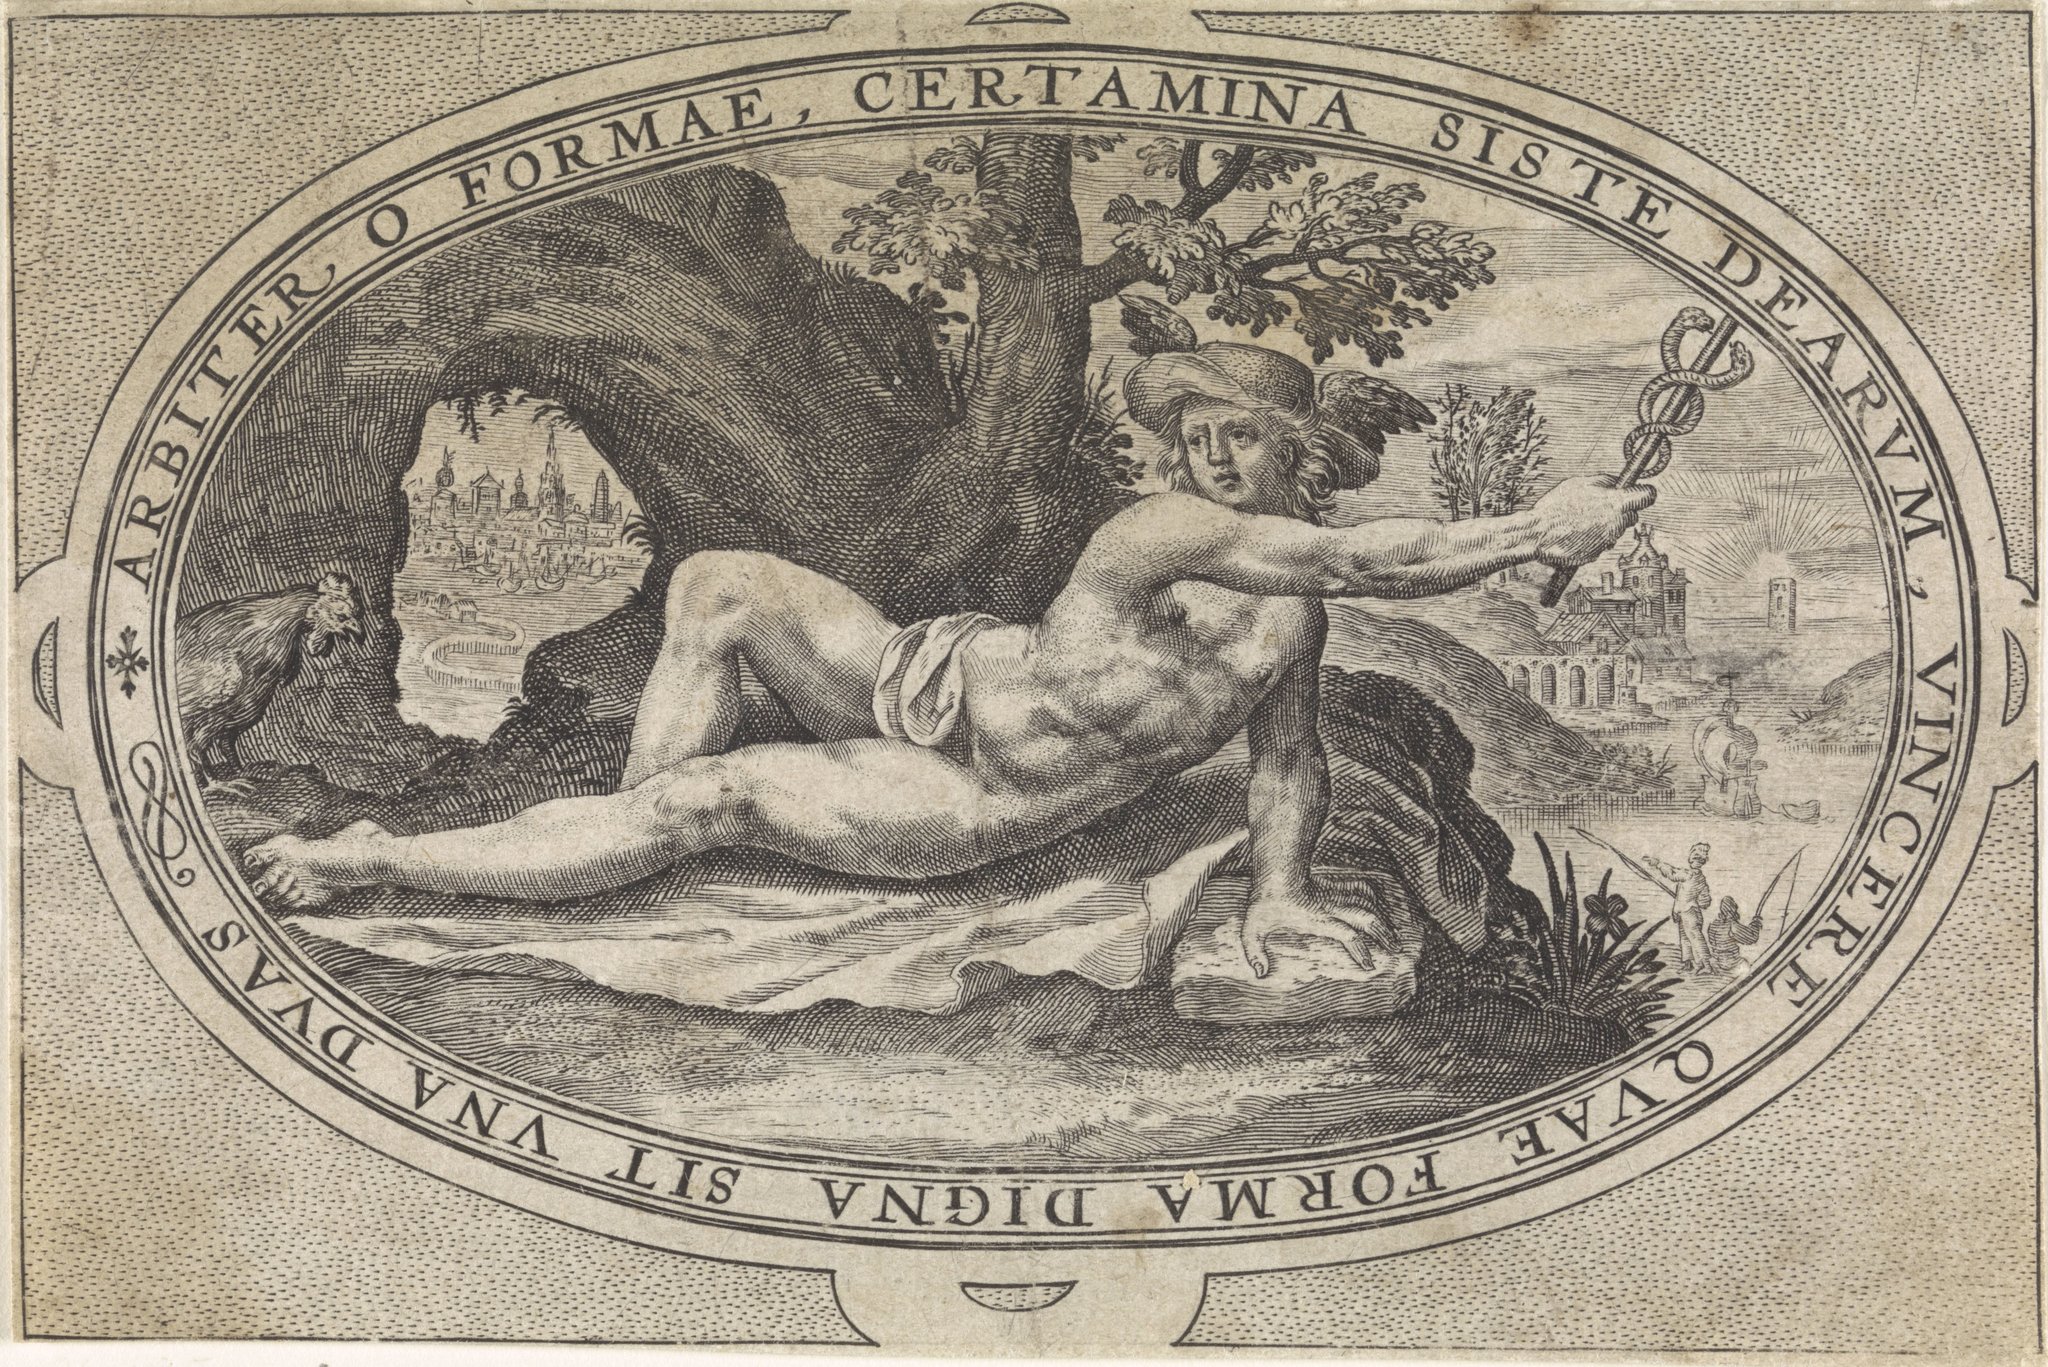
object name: print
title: Goden en godinnen betrokken bij het oordeel van Paris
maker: crispijn van de passe (i)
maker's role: draughtsman, print maker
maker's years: 1564-1637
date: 1592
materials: paper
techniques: engraving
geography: cologne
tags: (story of) mercury (hermes)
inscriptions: collector's mark: Lugt 2228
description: Landschap met Mercurius en zijn symbool de haan. Hanen trekken gewoonlijk de wagen van Mercurius. Mercurius draagt zijn gevleugelde helm de petasus. In zijn hand houdt hij de caduceus. In de omlijsting een randschrift in het Latijn dat verwijst naar de rol die Mercurius speelde in het Oordeel van Paris. Mercurius brengt de godinnen naar Paris en fungeert als tussenpersoon. Prent uit een serie van zes met Goden en Godinnen.